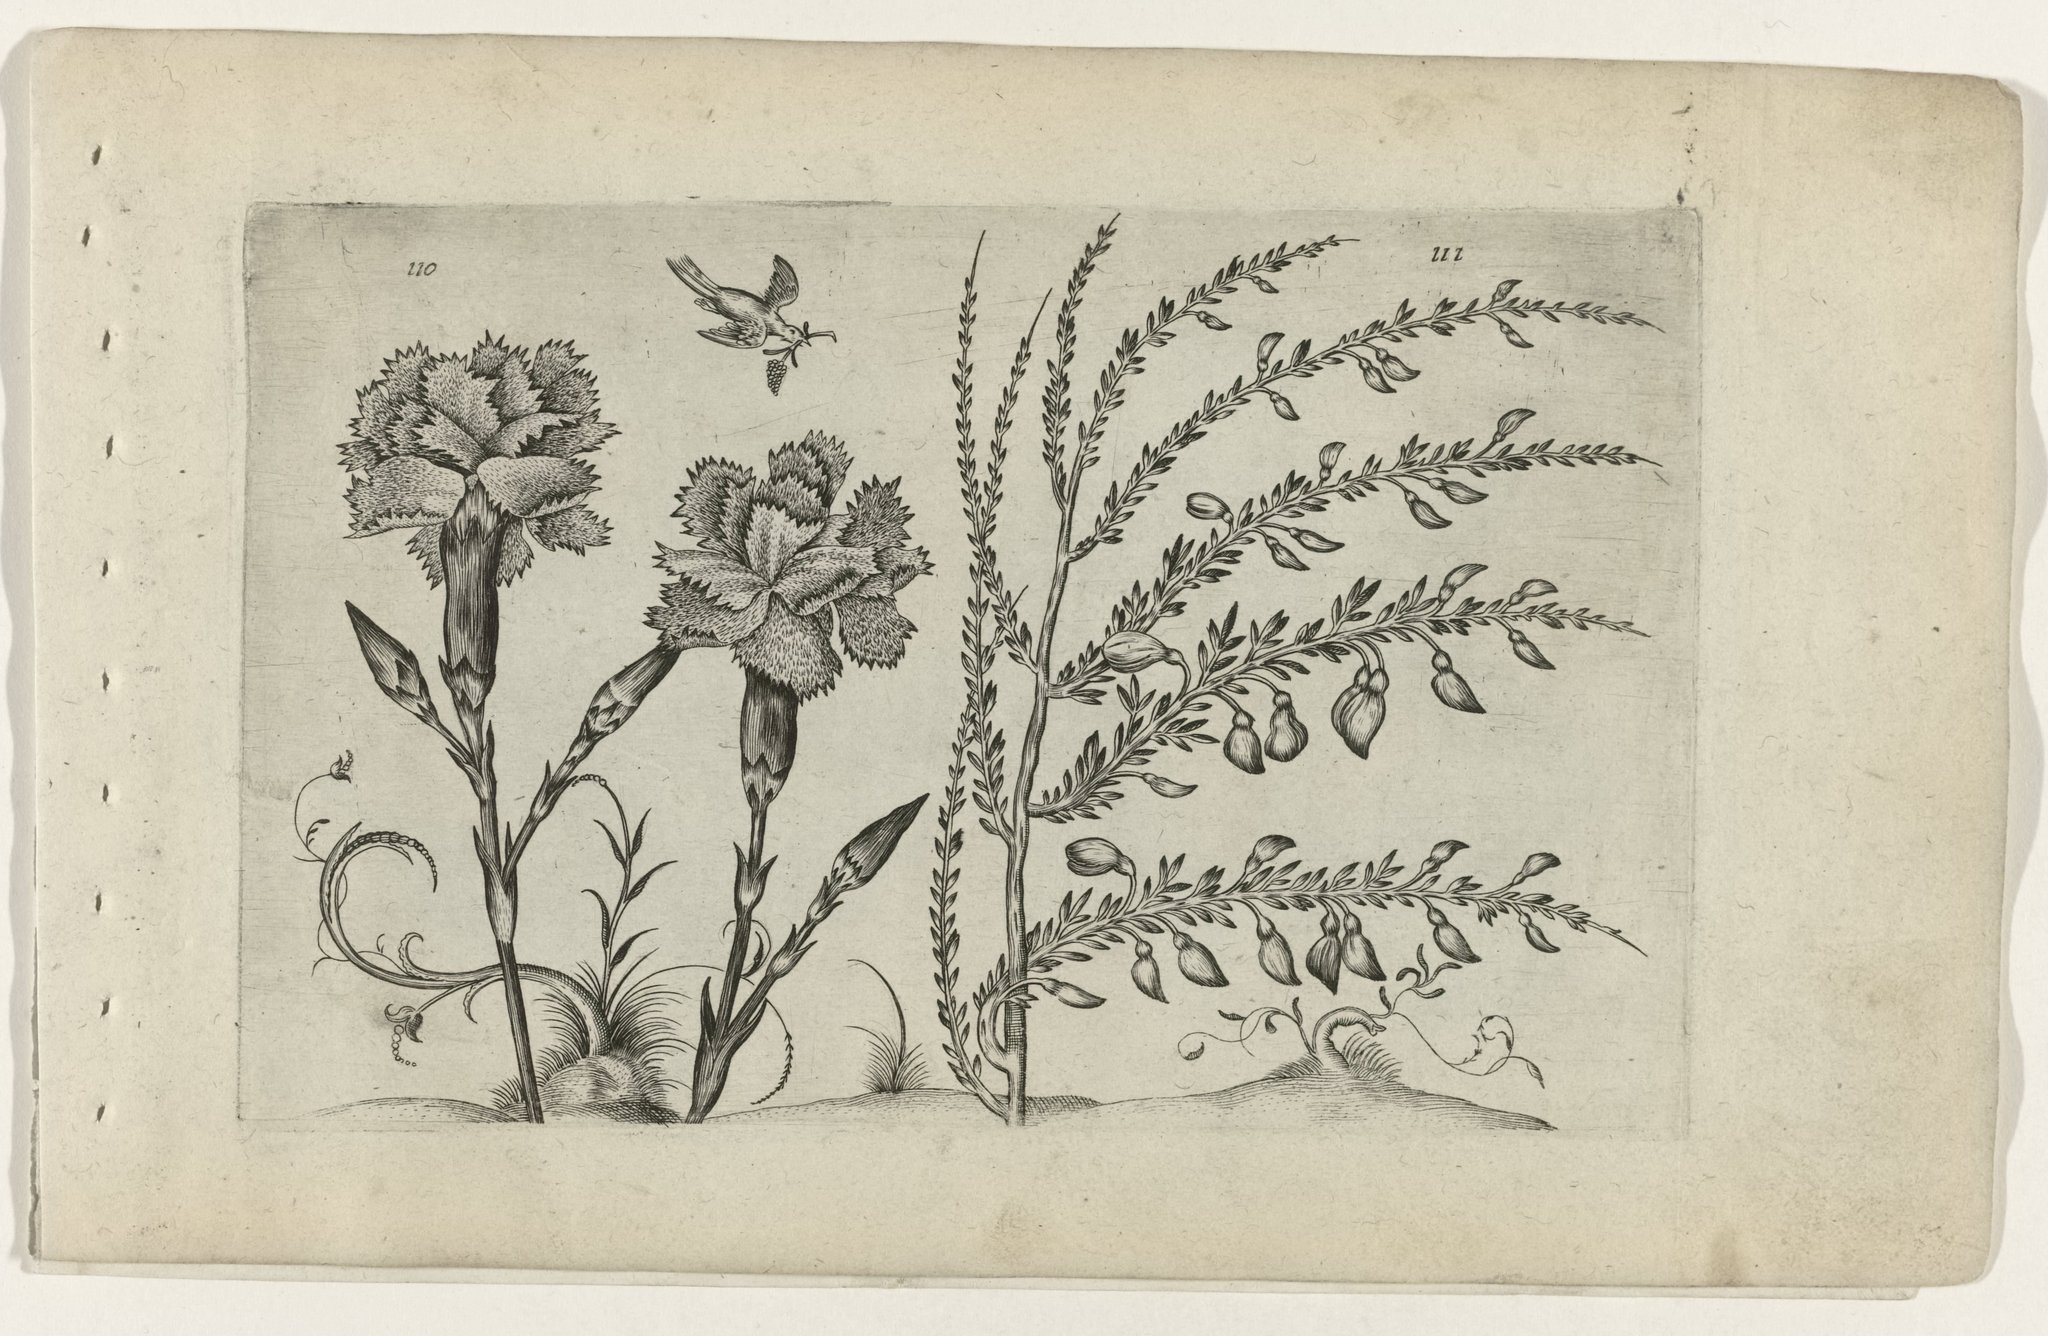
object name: album leaf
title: Cognoscite lilia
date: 1600-1604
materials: paper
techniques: engraving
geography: cologne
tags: flowers: broom, botany, flowers: carnation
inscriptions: collector's mark: Lugt 2228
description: De prenten RP-P-2012-24-1 t/m 61 waren oorspronkelijk als serie samengebonden. De naaigaten op de bladen zijn nog zichtbaar. Het betreft de reeks getiteld: Cognoscite lilia, bestaande uit een titelprent en 60 gravures met 119 genummerde weergaven van planten, bloemen en vruchten, versierd met rinceaux en kleine voorstellingen van dieren. Het gaat om proefdrukken van deze reeks gravures, voor de opschriften en, deels, voor de nummering. Op enkele prenten zijn de nummers met de hand aangebracht. Op de titelprent ontbreekt nog het adres van Crispijn de Passe en Hans Woutneel. De titel is hoogstwaarschijnlijk gegraveerd door Matthias Quad. Deze werkte voor De Passe in Keulen tot 1604. De reeks moet in dit jaar of daarvoor tot stand zijn gebracht. In ieder geval voor 1608, aangezien de uitgever Hans Woutneel in of voor dat jaar overleed. In ieder geval voor 1608, aangezien de uitgever Hans Woutneel in of voor dat jaar overleed. De gravures worden door Ilja Veldman en Anthony Griffiths beschouwd als eigenhandig werk van Crispijn de Passe I. Een van de prenten uit de reeks ontbreekt (nr 21-22) en is vervangen door een ingekleurde afdruk uit een latere uitgave (RP-P-2012-24-61), die onder de titel Altera Pars is opgenomen in de Hortus Floridus, uitgegeven door Crispijn de Passe I en die verder bestaat uit platen van Crispijn de Passe II. De prenten afkomstig uit deze uitgave zijn op de verso voorzien van tekst in boekdruk. De vervangende prent maakte geen deel uit van de gebonden serie aangezien dit blad als enige geen naaigaten heeft. Een deel van de planten, bloemen en vruchten in de Cognoscite lilia gaat terug of is gebaseerd op een reeks aquarellen van Jacques LeMoyne uit circa 1580 en uit 1585, nu in het Victoria and Albert Museum en de British Museum (zie P. Hulton, Jacques LeMoyne, Londen 1977, dl 1, p. 156-162 en p. 165-173).